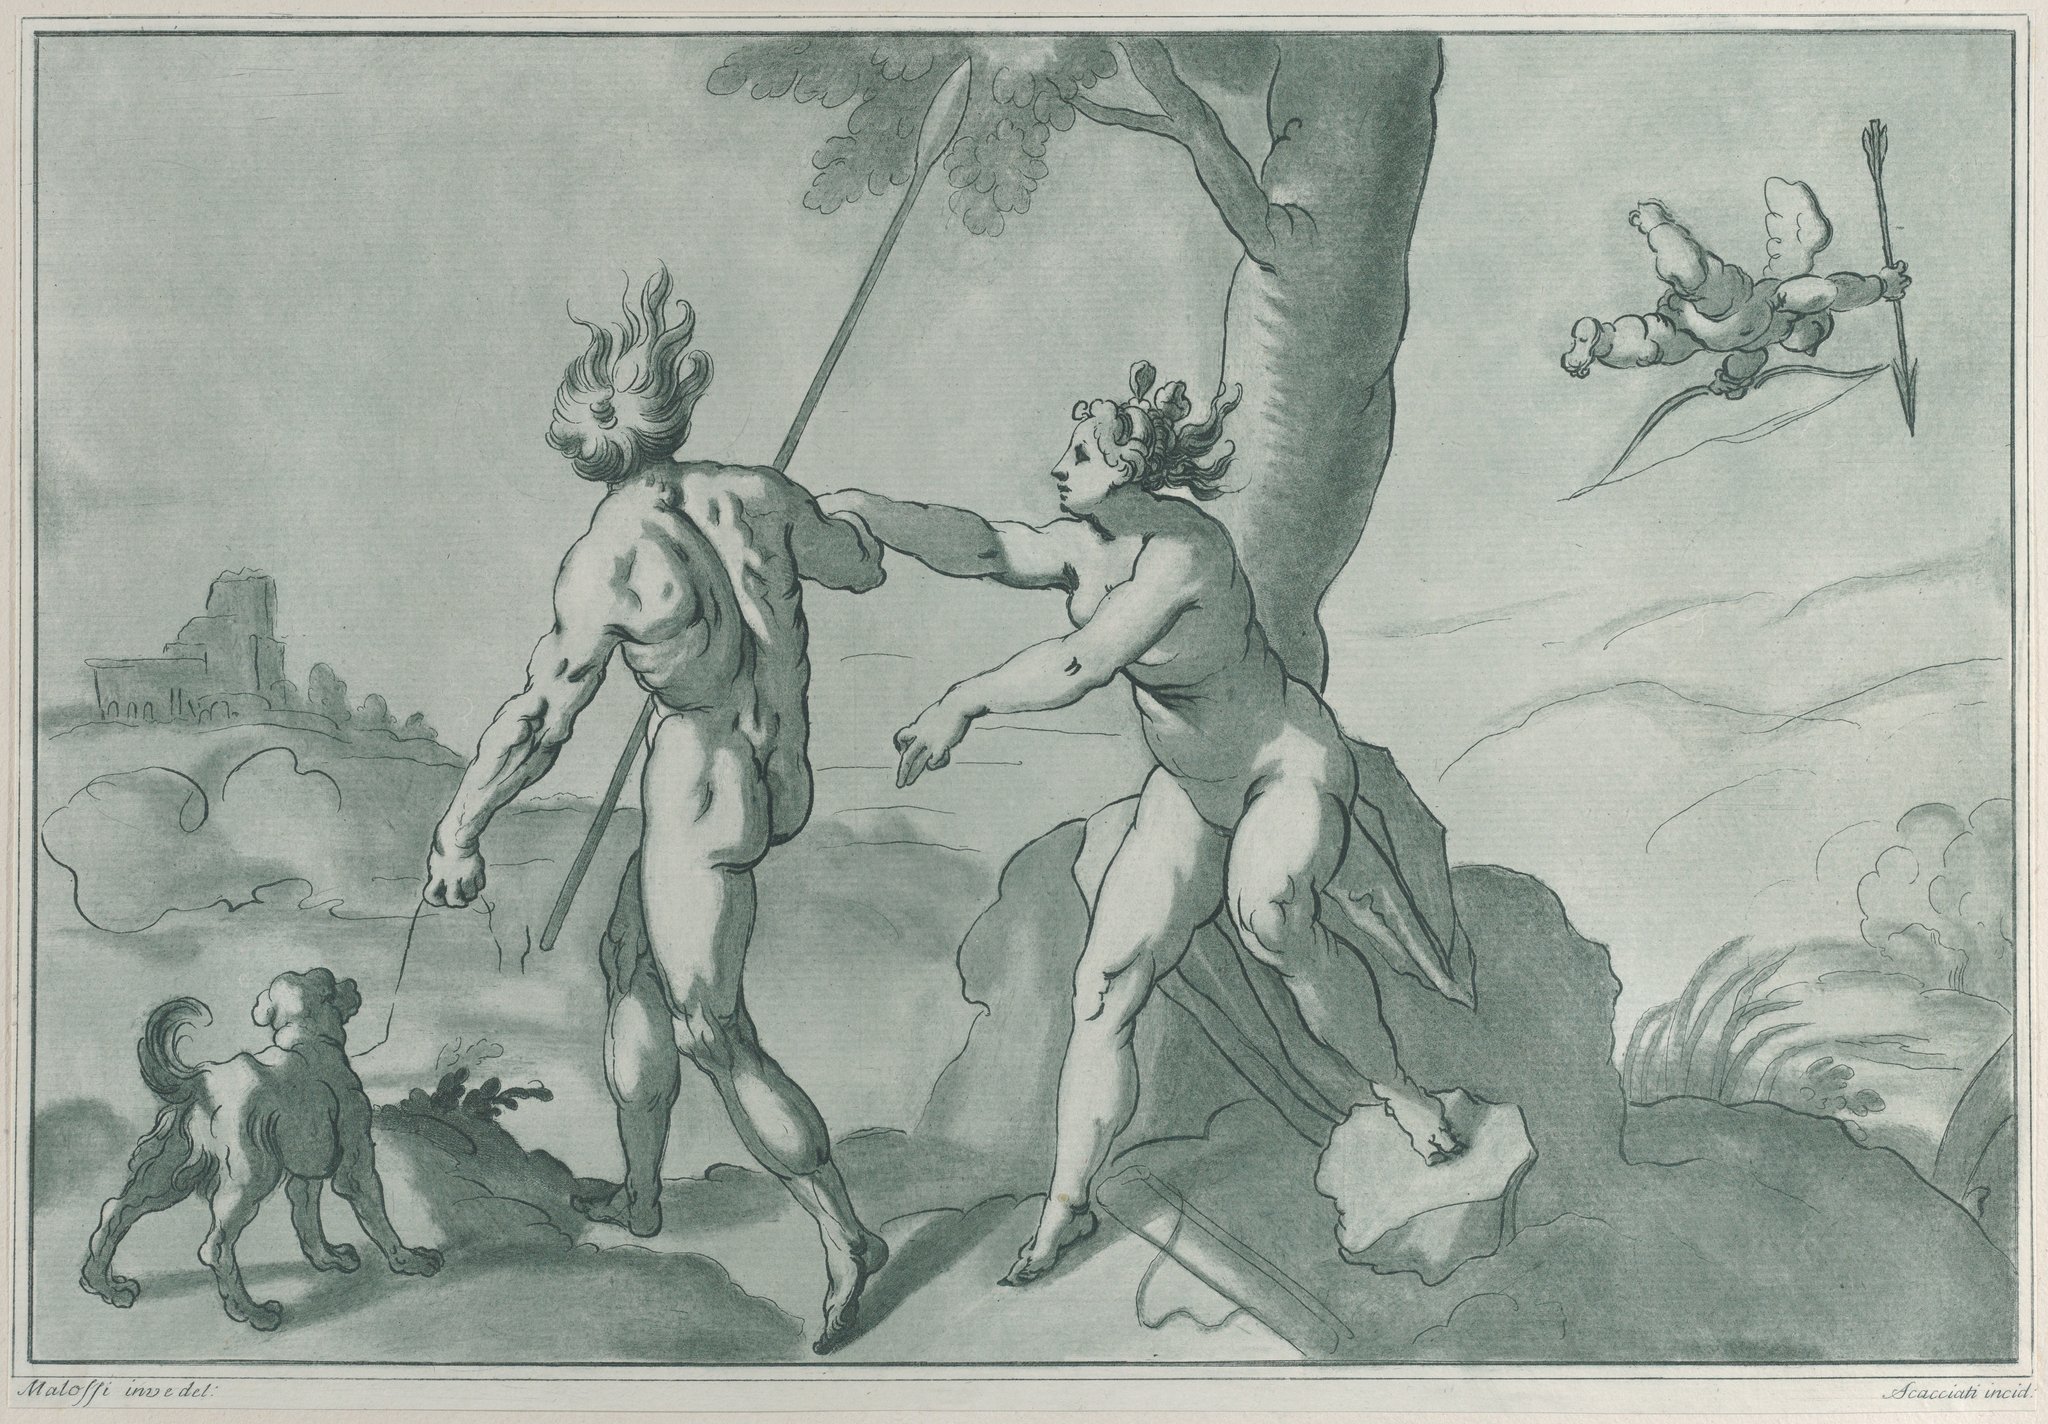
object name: print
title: Venus and Adonis (?), nude in a landscape with a dog at left and Cupid at upper right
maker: andrea scacciati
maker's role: artist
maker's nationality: italian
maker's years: 1725-1771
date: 1750-1770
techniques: aquatint, etching